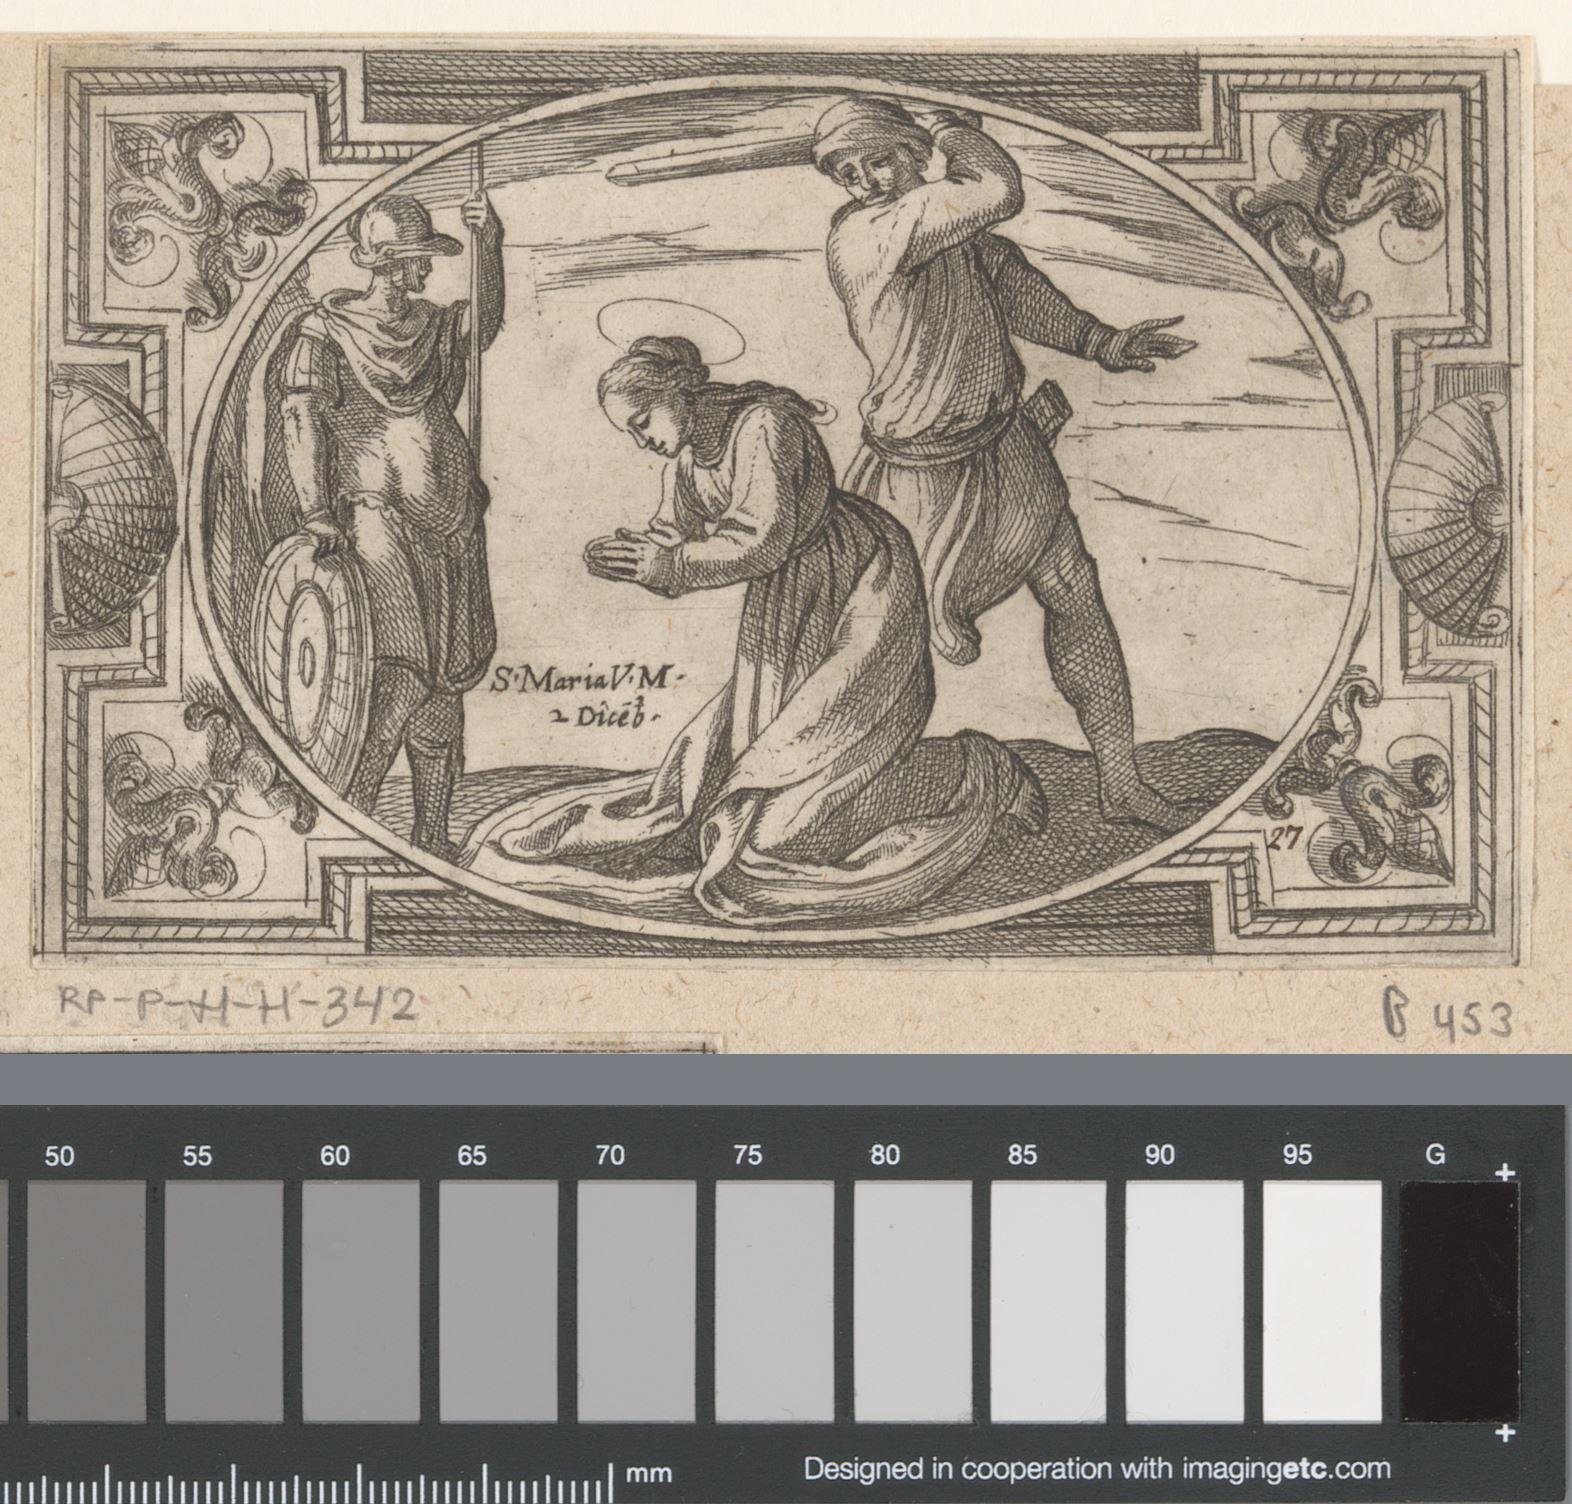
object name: print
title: H. Maria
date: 1565-1630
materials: paper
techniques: etching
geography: rome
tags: martyr(s) (often with palm-branches) - qq - female martyr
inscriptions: number: ‘27’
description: Deze prent maakt deel uit van een reeks van 73 prenten (+ titelprent) met voorstellingen van Romeinse martelaressen.